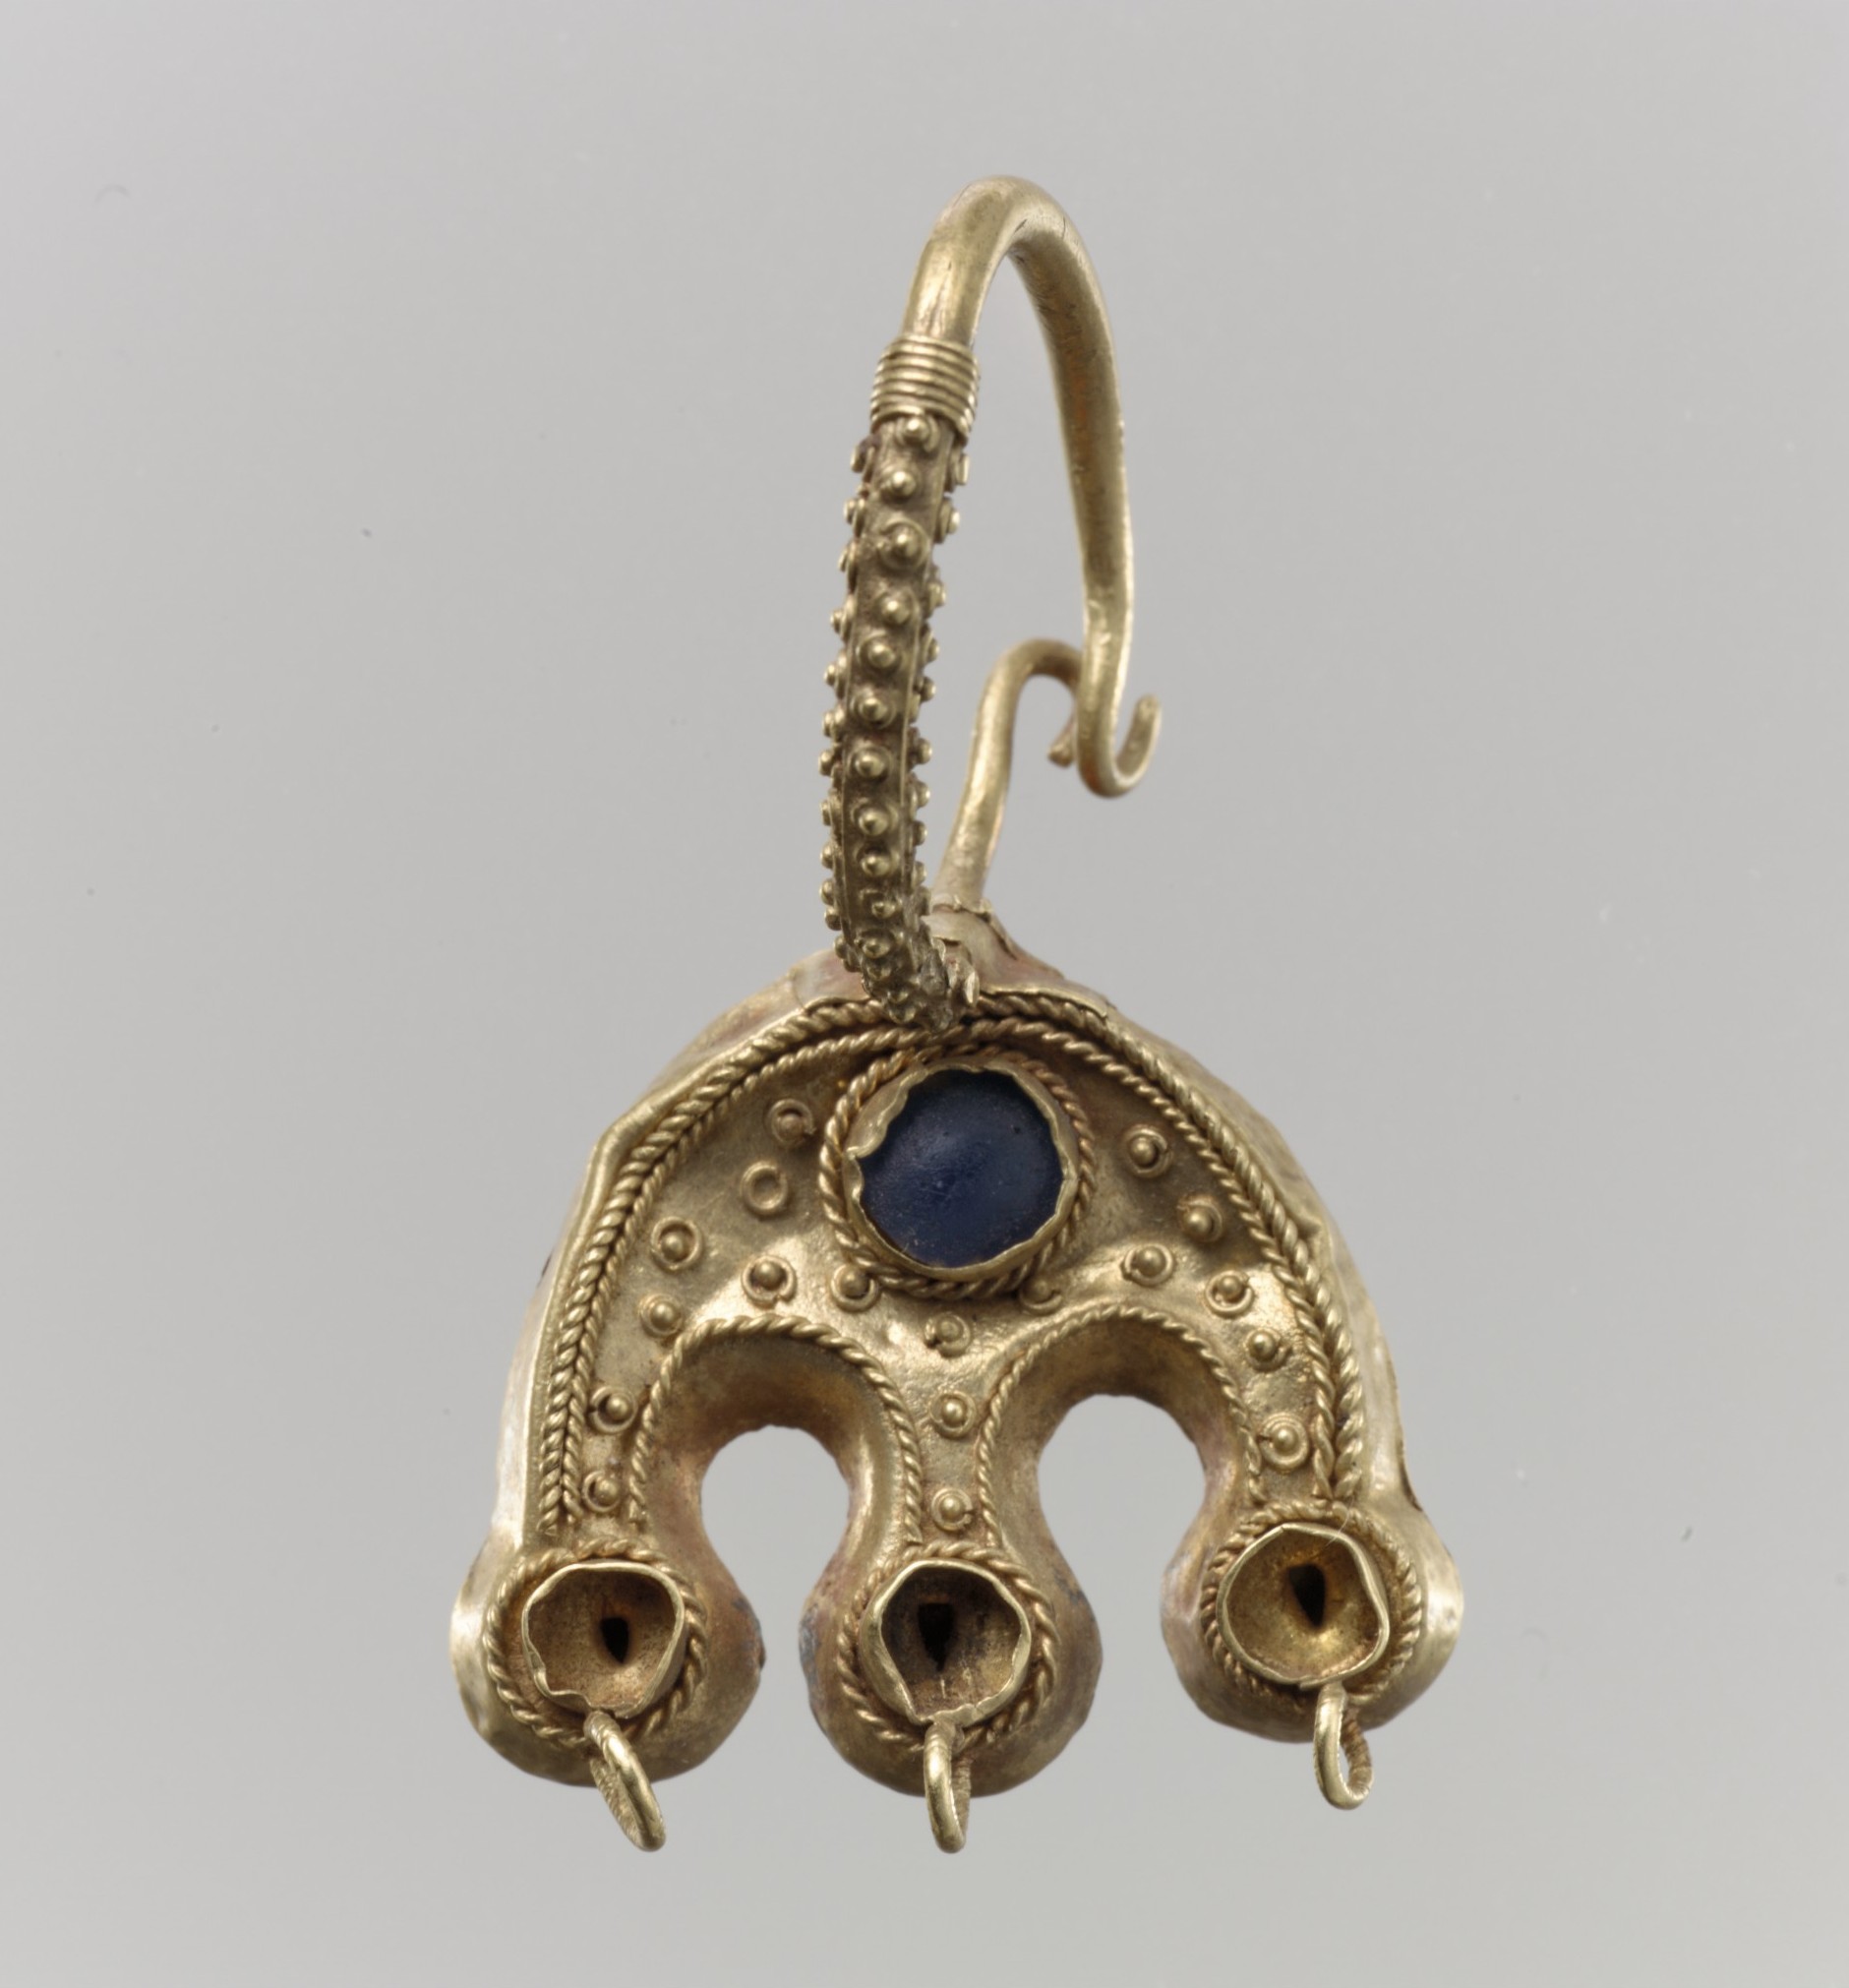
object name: earring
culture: byzantine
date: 501-700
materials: glass, gold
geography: italy